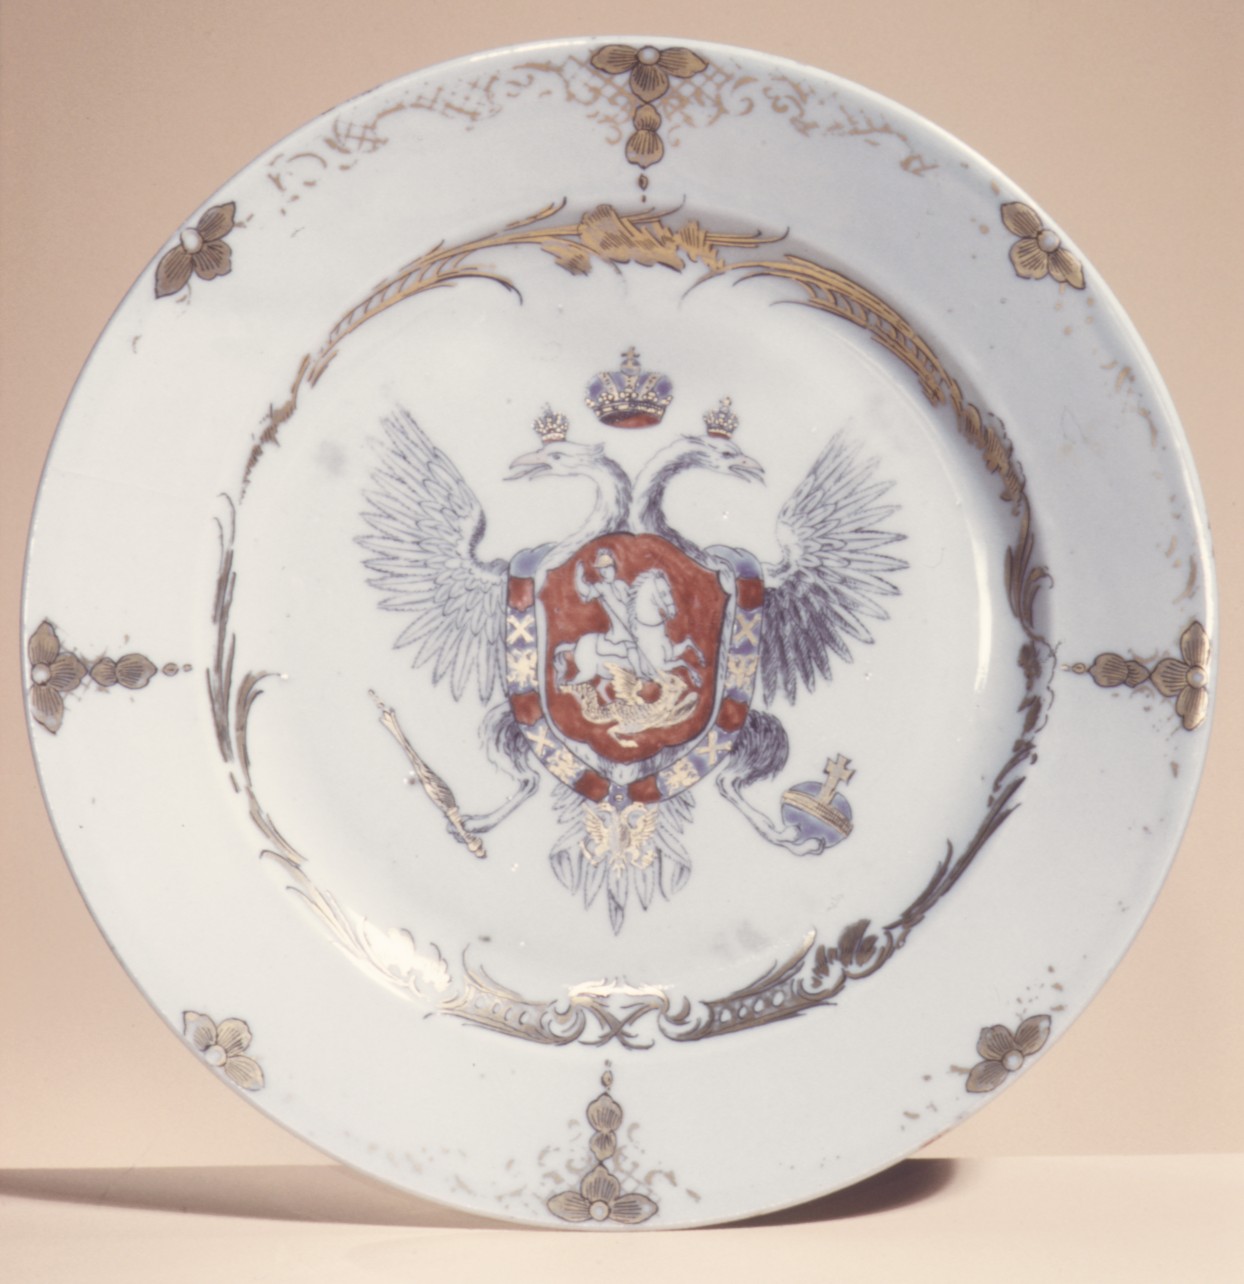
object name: dish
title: Dish (one of two)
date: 1775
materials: hard paste porcelain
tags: coat of arms